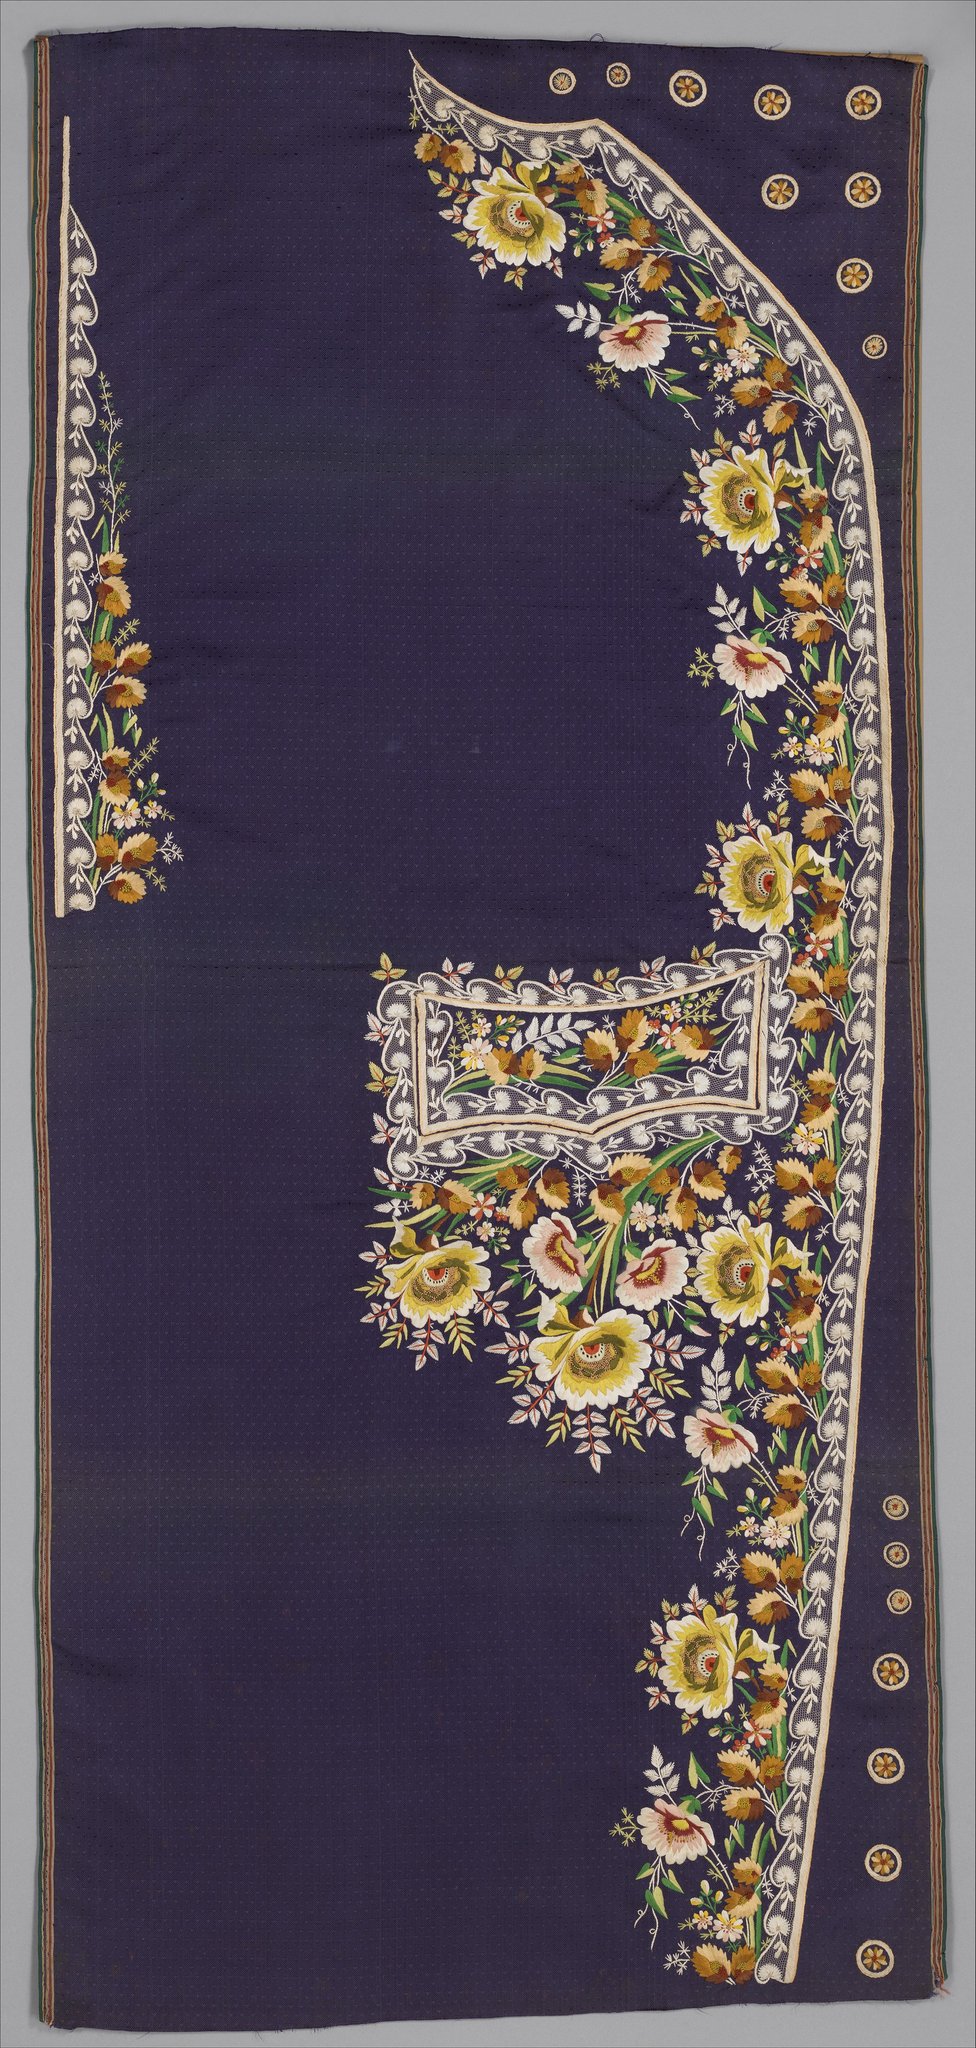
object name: suit panel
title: Embroidered panels for a man's suit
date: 1780-1789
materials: textile, silk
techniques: embroidery, stitching, weave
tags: flowers